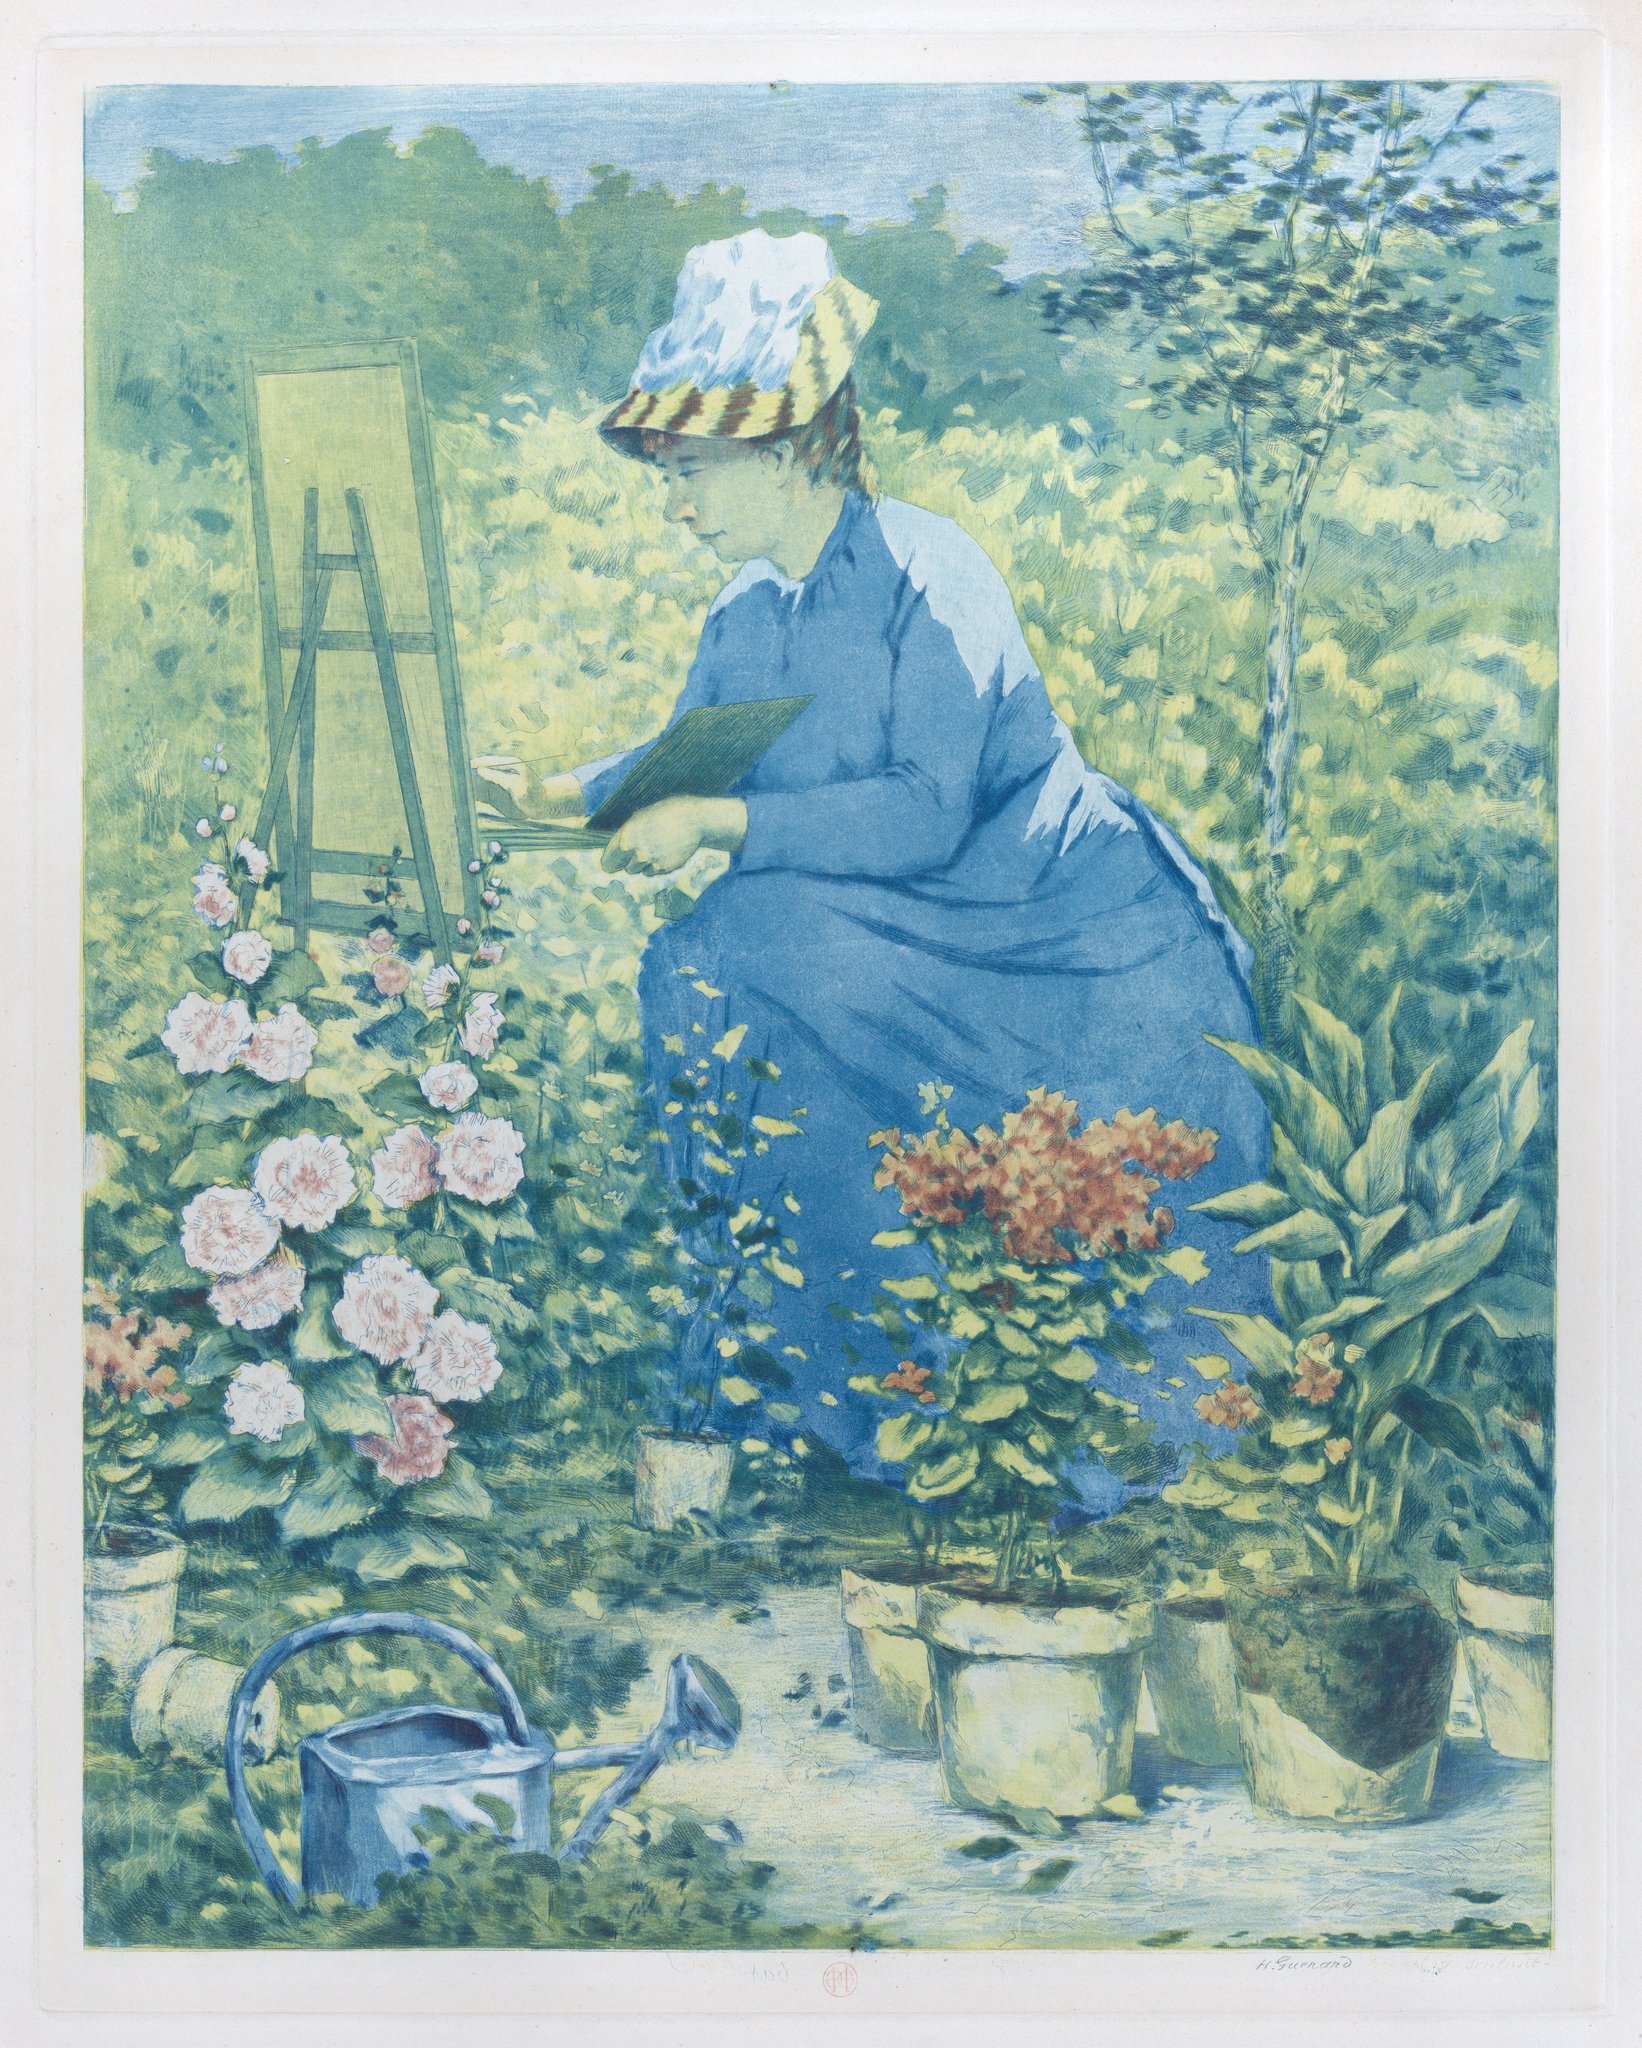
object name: print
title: Jeanne Gonzales Painting in the Garden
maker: henri charles guérard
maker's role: artist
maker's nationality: french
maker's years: 1846-1897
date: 1885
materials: paper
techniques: aquatint, drypoint, roulette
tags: painting,gardens,women